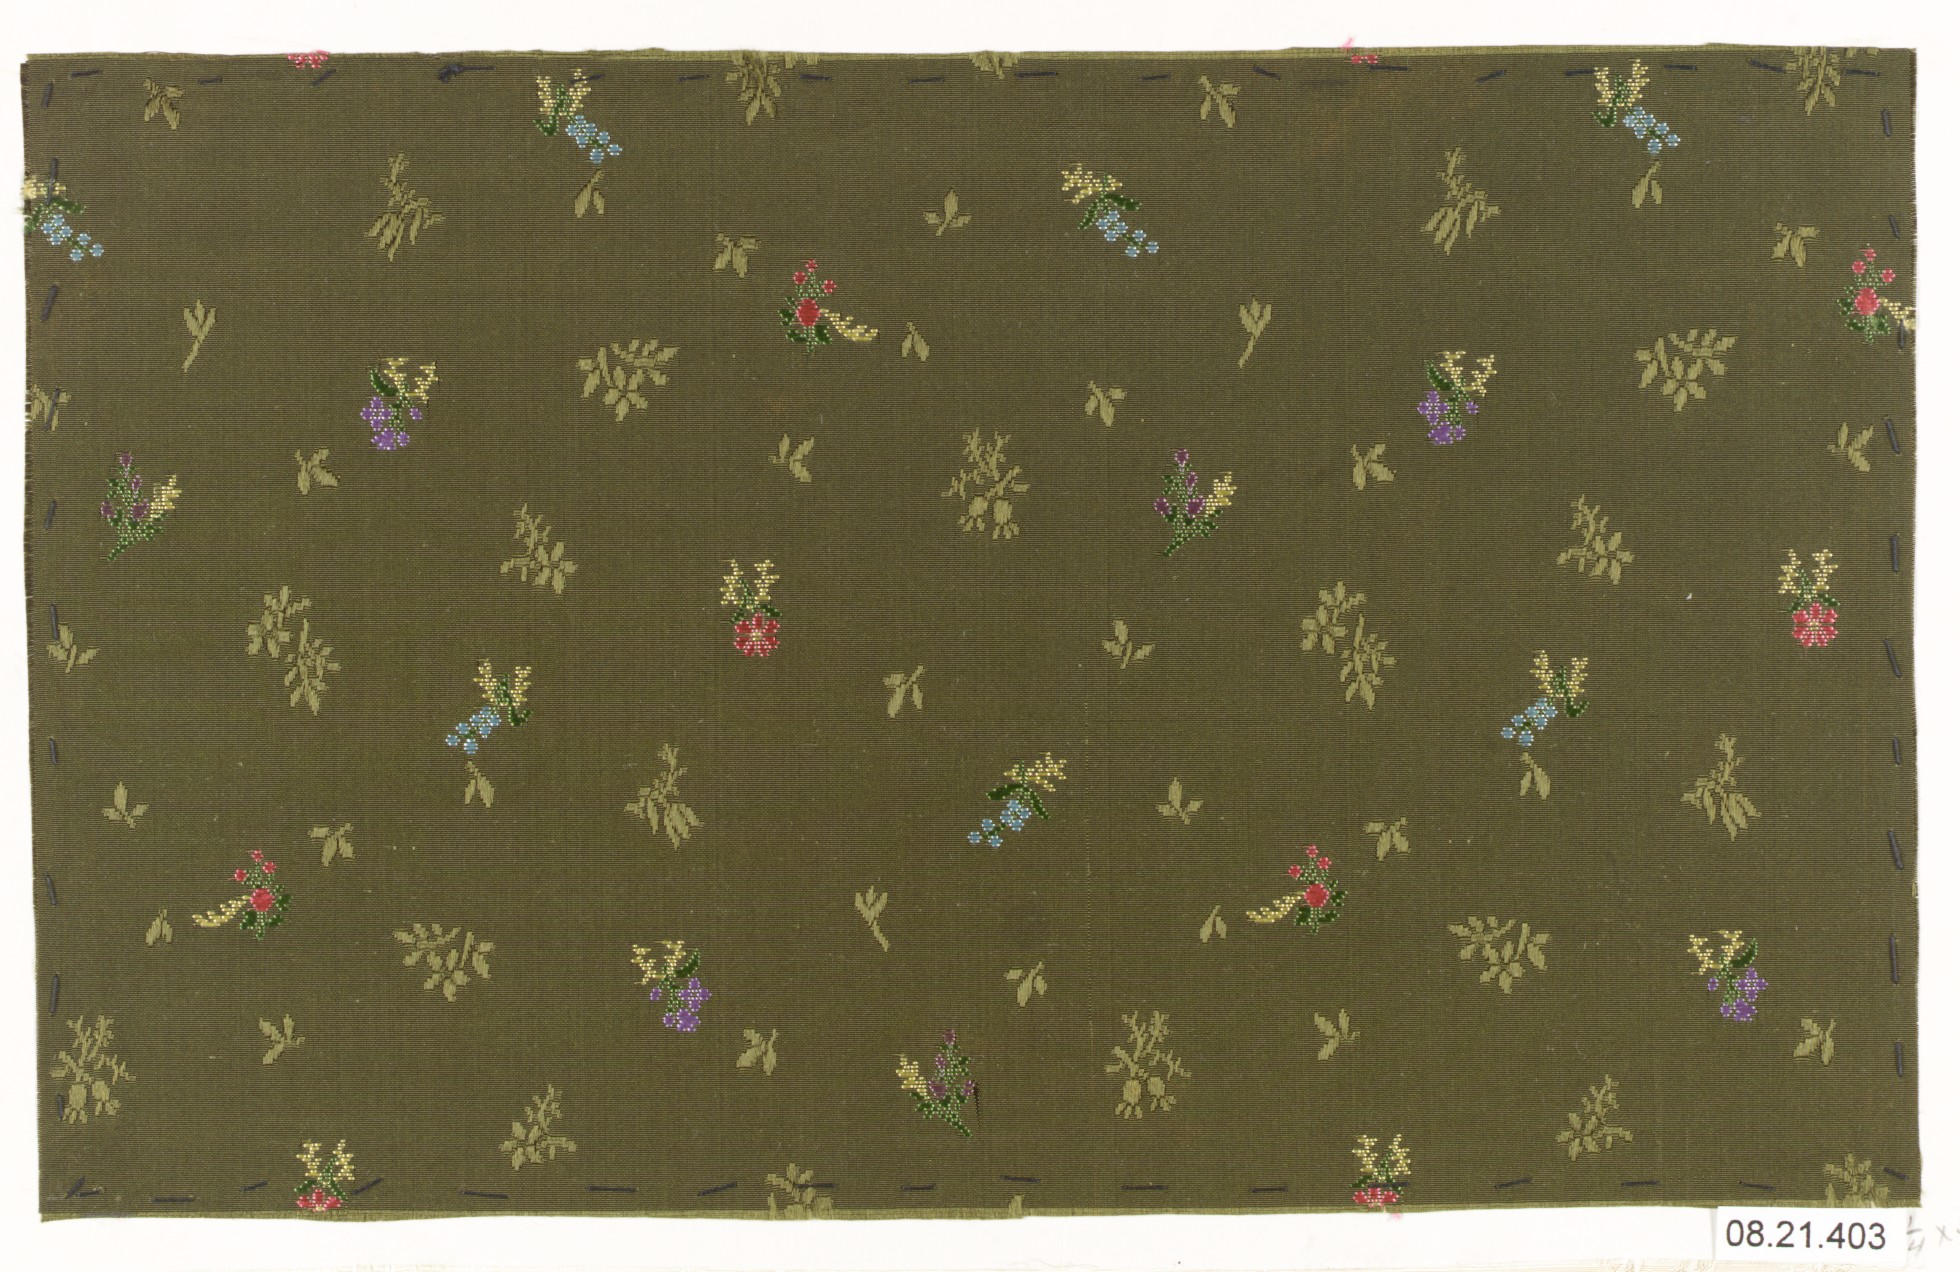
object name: textile sample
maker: Anonymous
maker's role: designer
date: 1900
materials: silk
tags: flowers,leaves